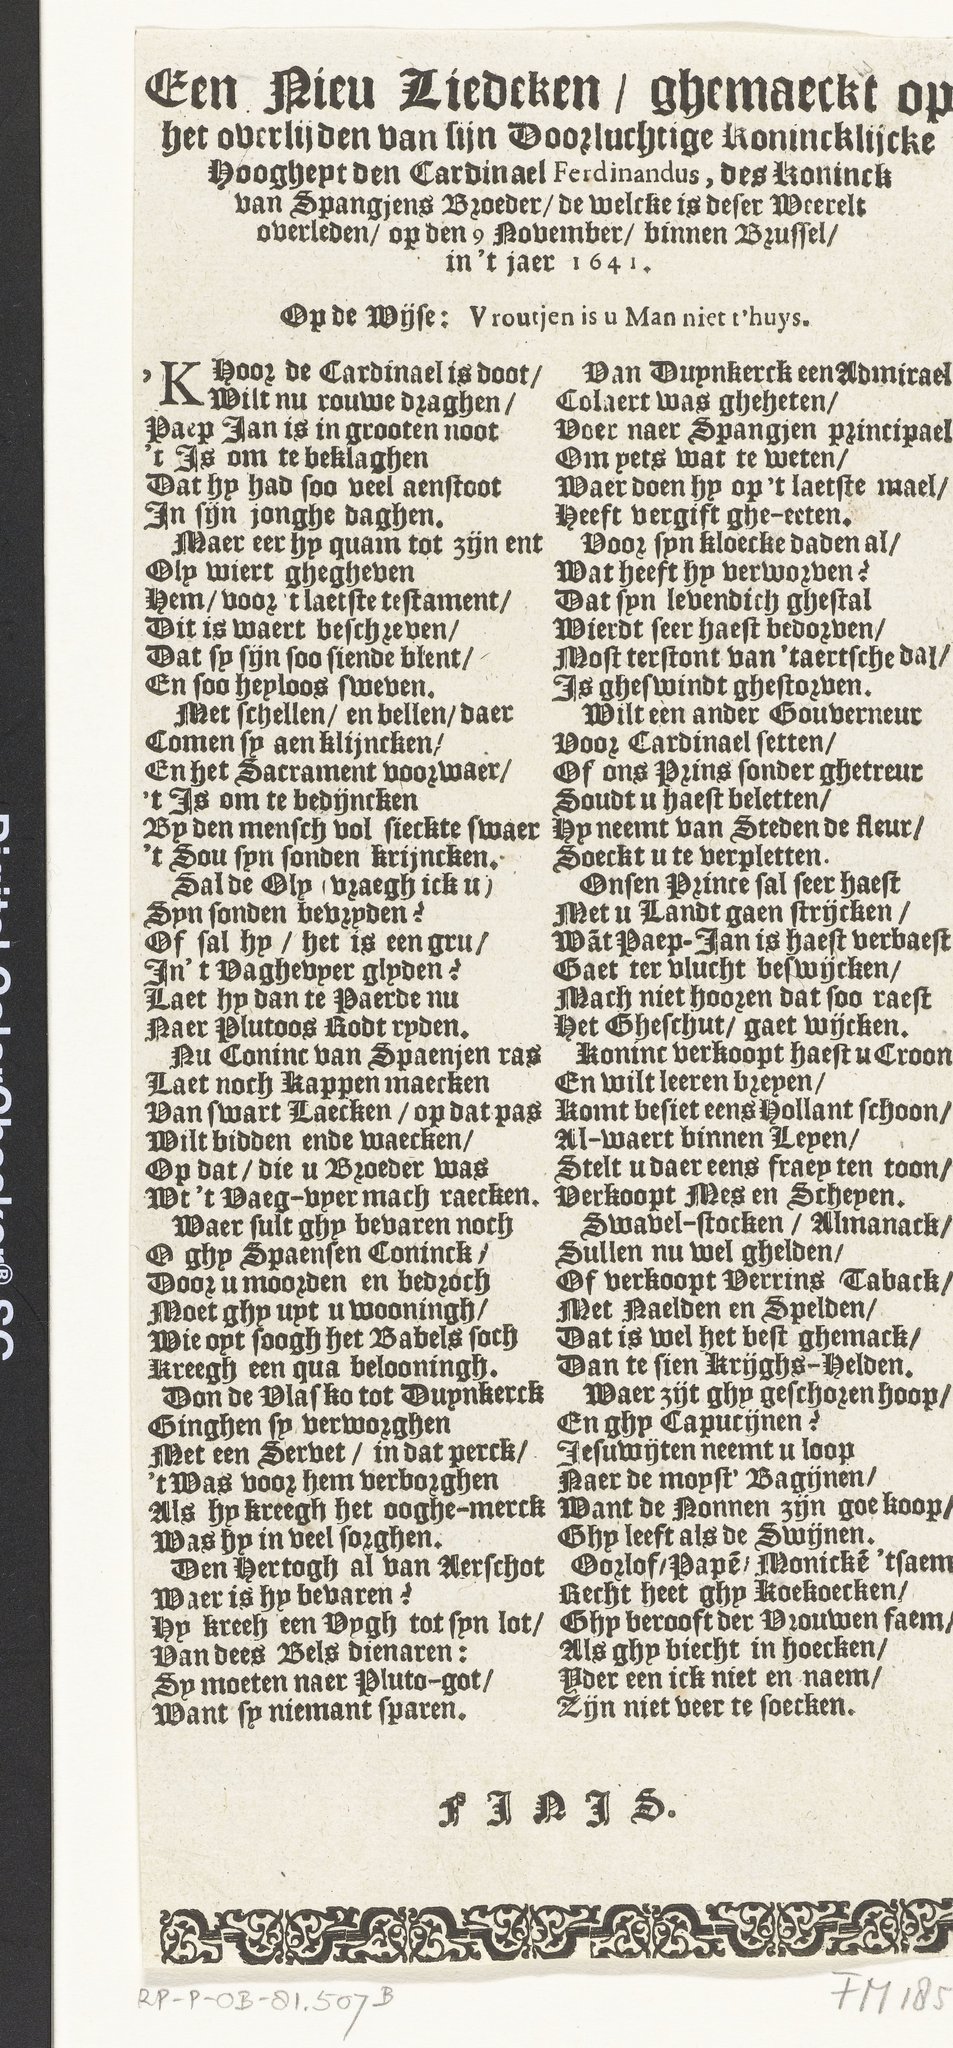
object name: song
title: Lied op de overleden kardinaal-infant Ferdinand van Oostenrijk, 1641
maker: Anonymous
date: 1641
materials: paper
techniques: letterpress printing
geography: northern netherlands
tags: brussels, landvoogd der zuidelijke nederlanden ferdinand van oostenrijk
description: Spotlied op het overlijden van de kardinaal-infant Ferdinand van Oostenrijk op 9 november 1641. Liedtekst in 2 kolommen in het Nederlands. Bij het lied behoort een afbeelding.